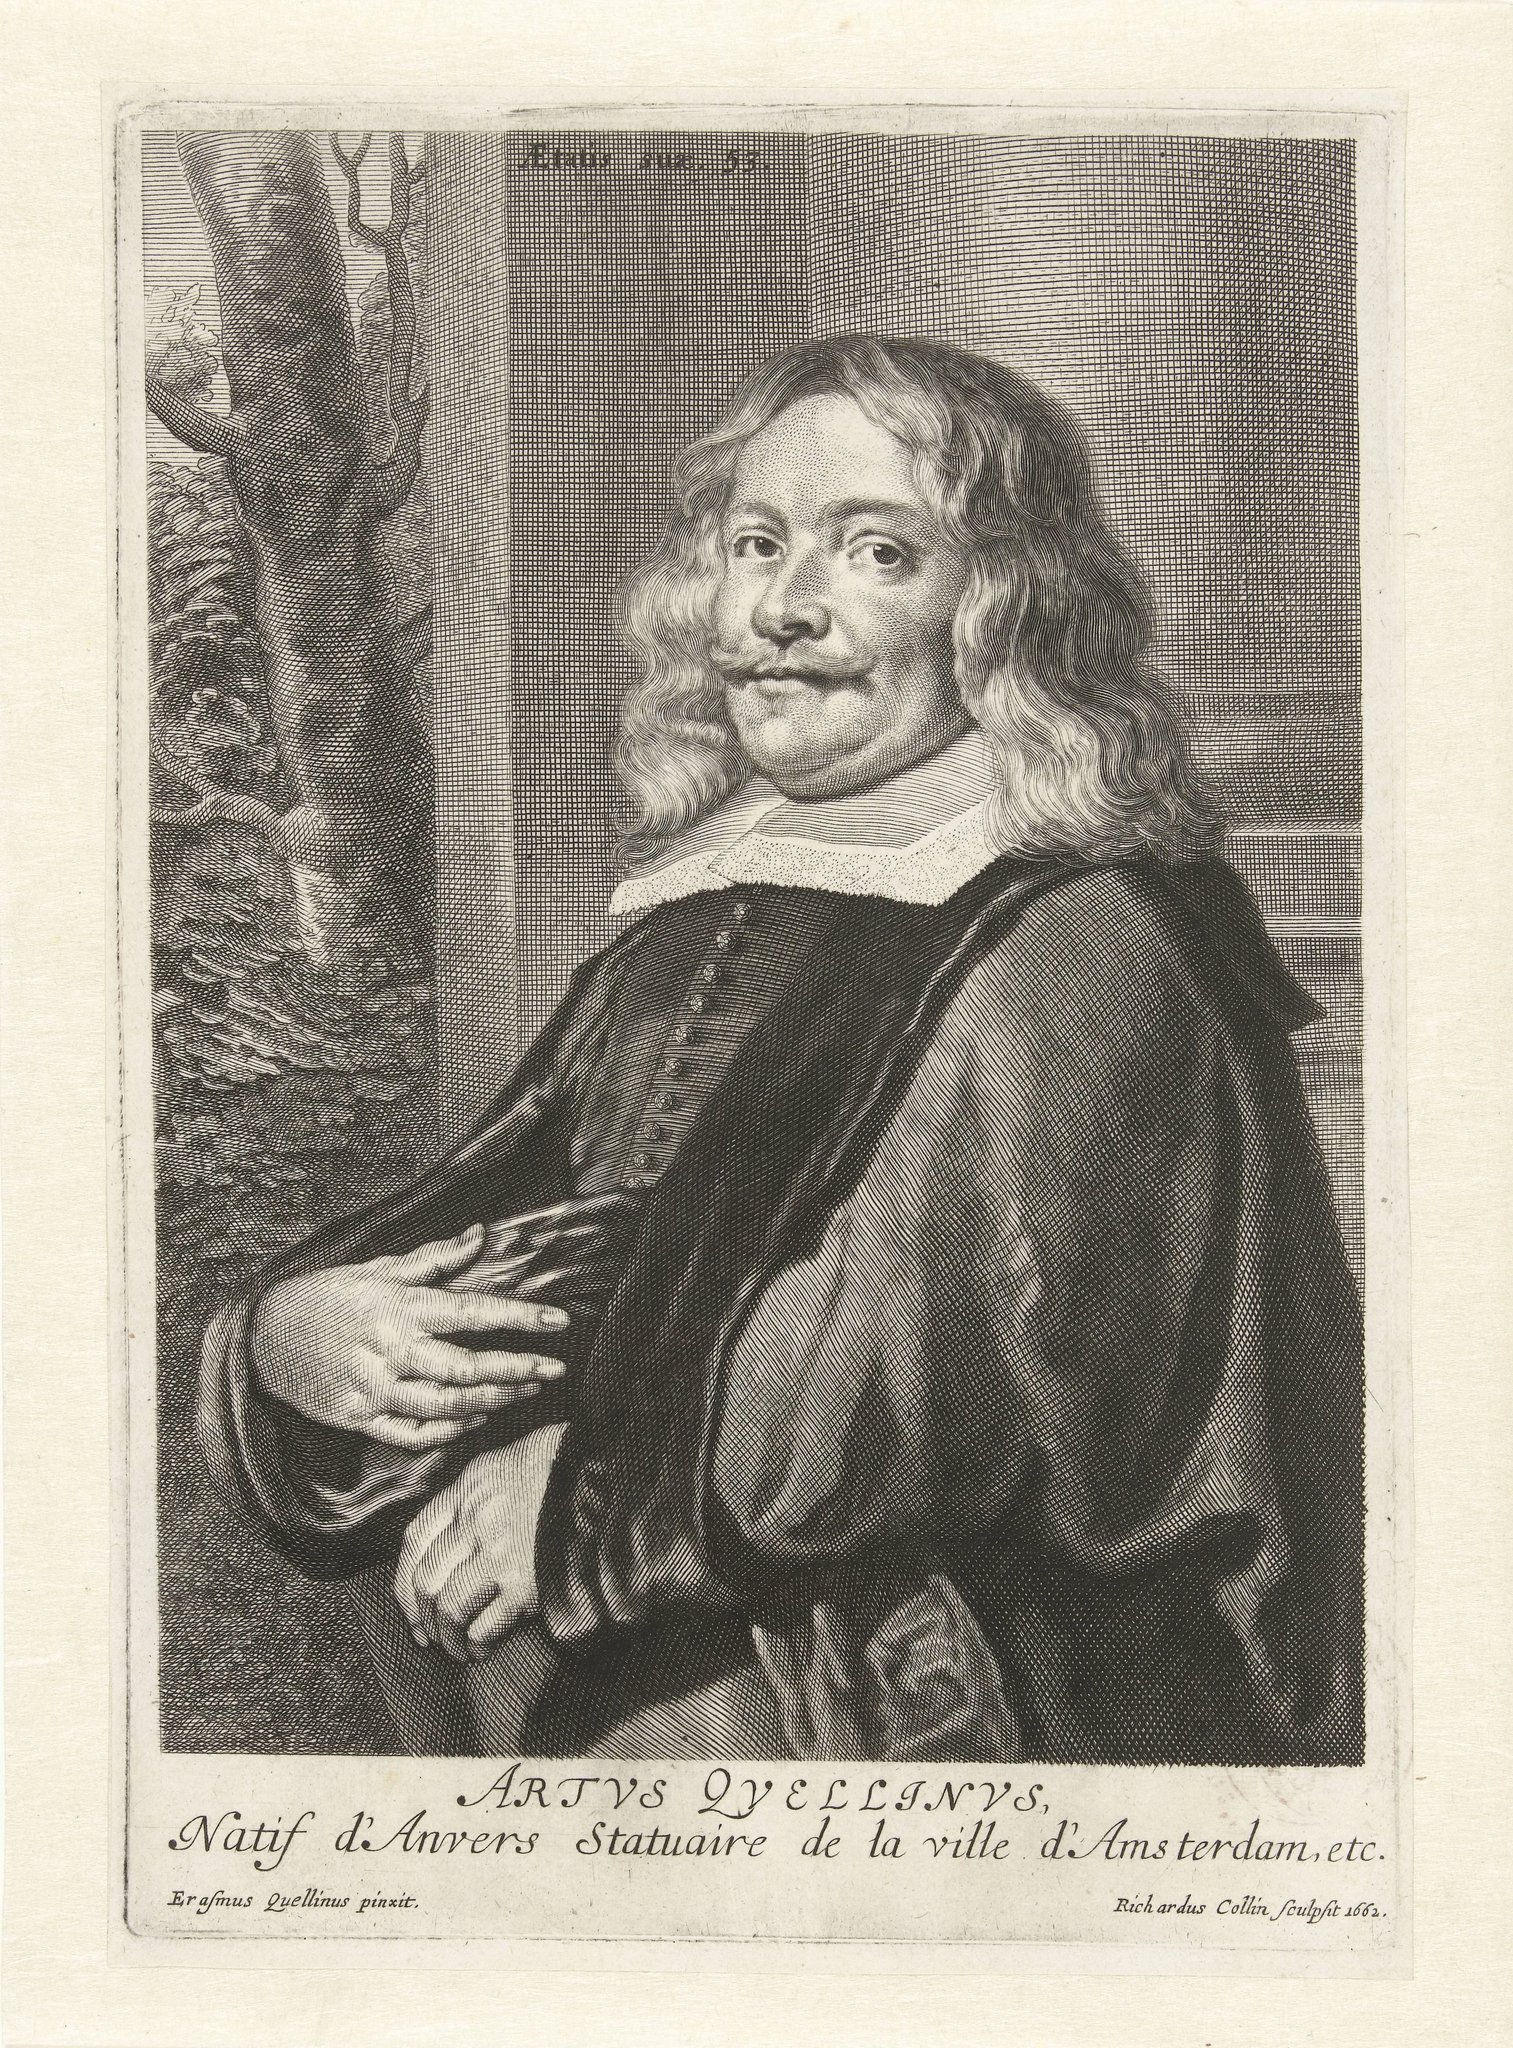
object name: print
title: Portret van de beeldhouwer Artus Quellinus op 53-jarige leeftijd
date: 1662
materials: paper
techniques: engraving, etching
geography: antwerp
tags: antwerp, print maker, draughtsman, sculptor, artus quellinus (i)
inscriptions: collector's mark: Lugt 240